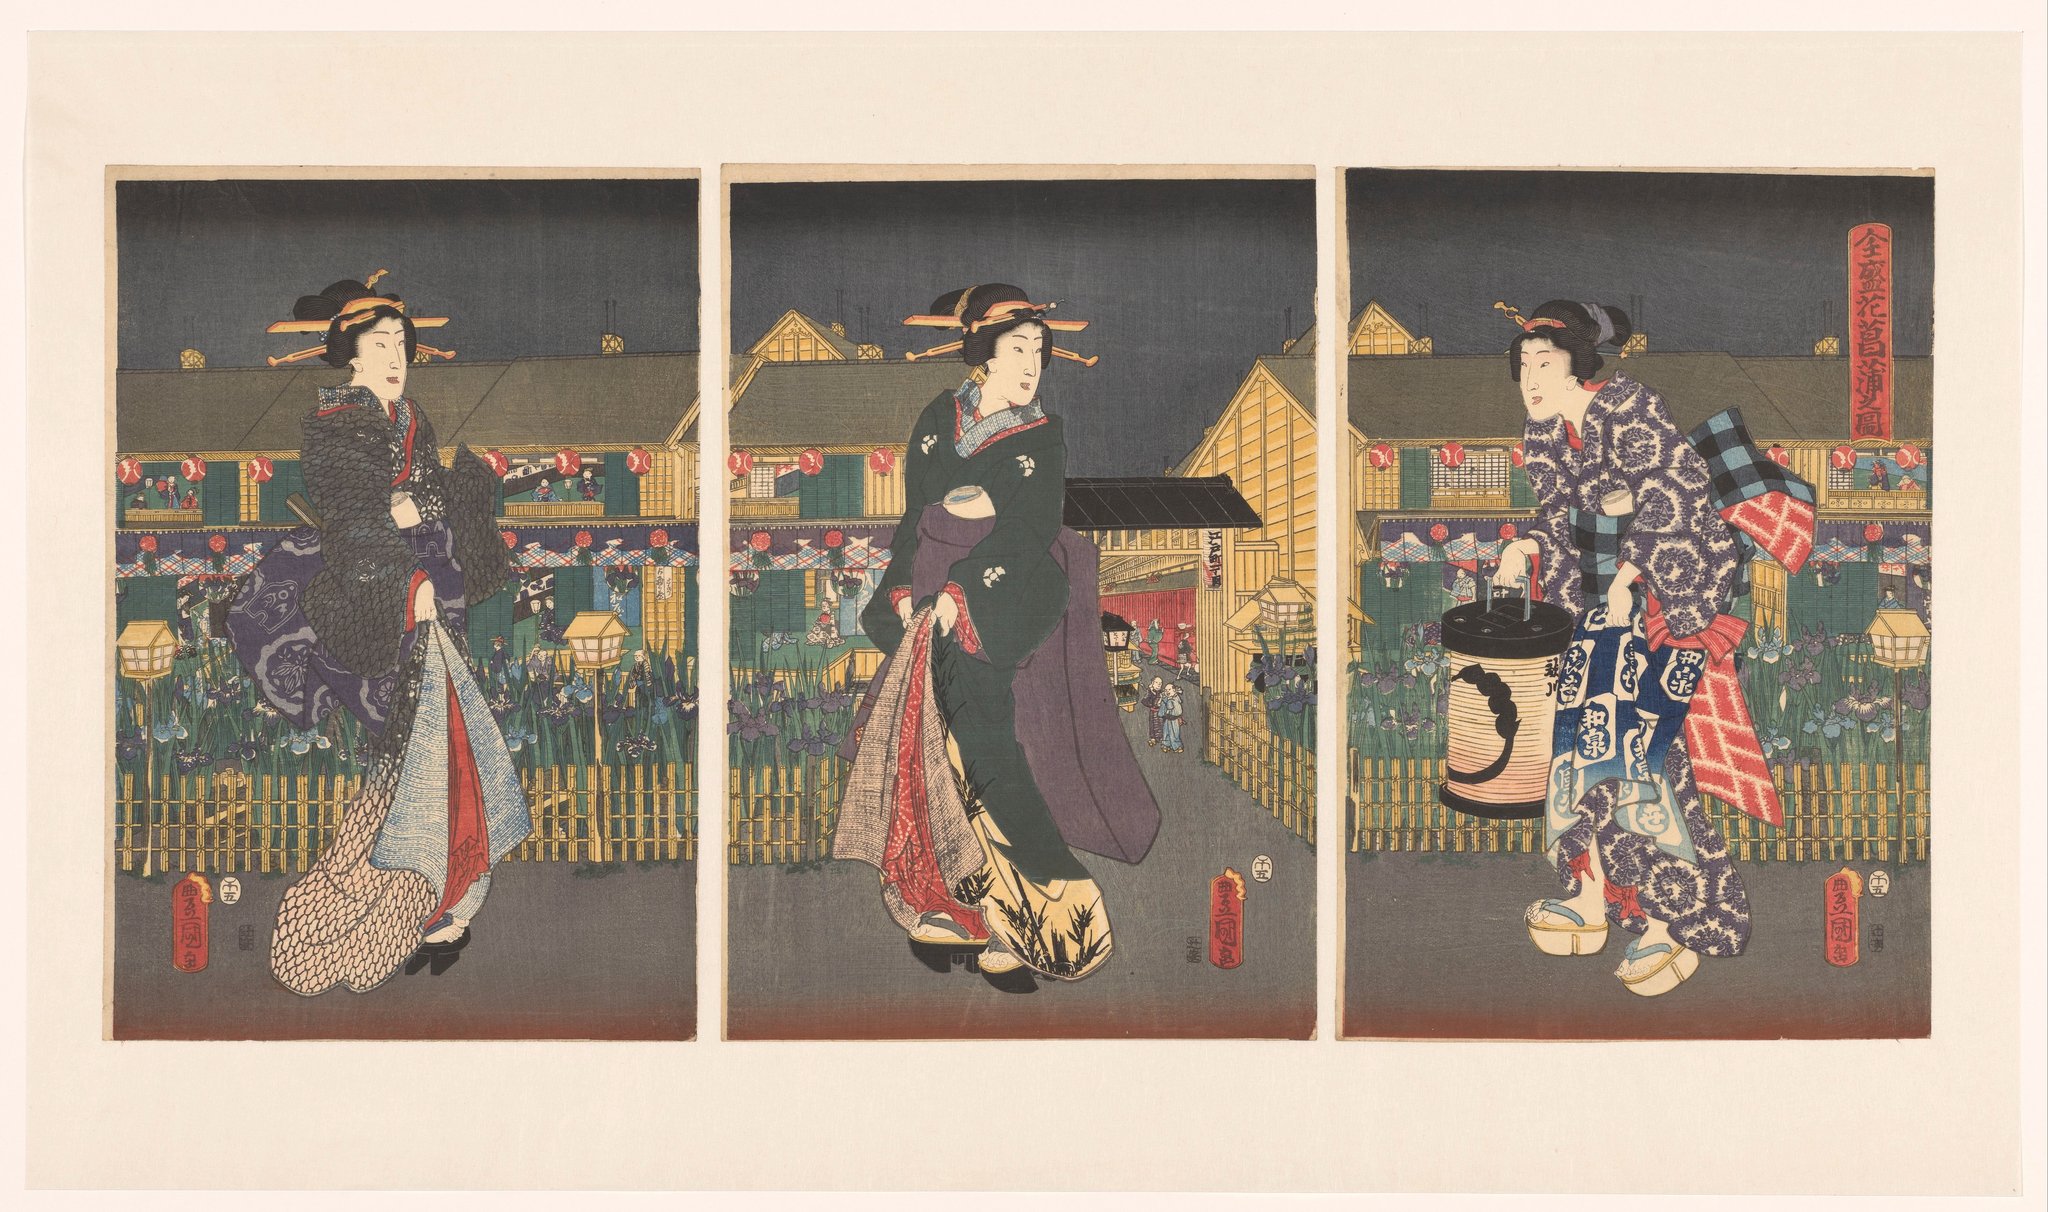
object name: triptych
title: Zensei hana shobu no zu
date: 1805-1858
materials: paper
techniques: woodcut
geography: japan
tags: flower-bed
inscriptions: date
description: Drie vrouwen, wandelend bij avond langs bloeiende irissen, waarachter theehuizen.